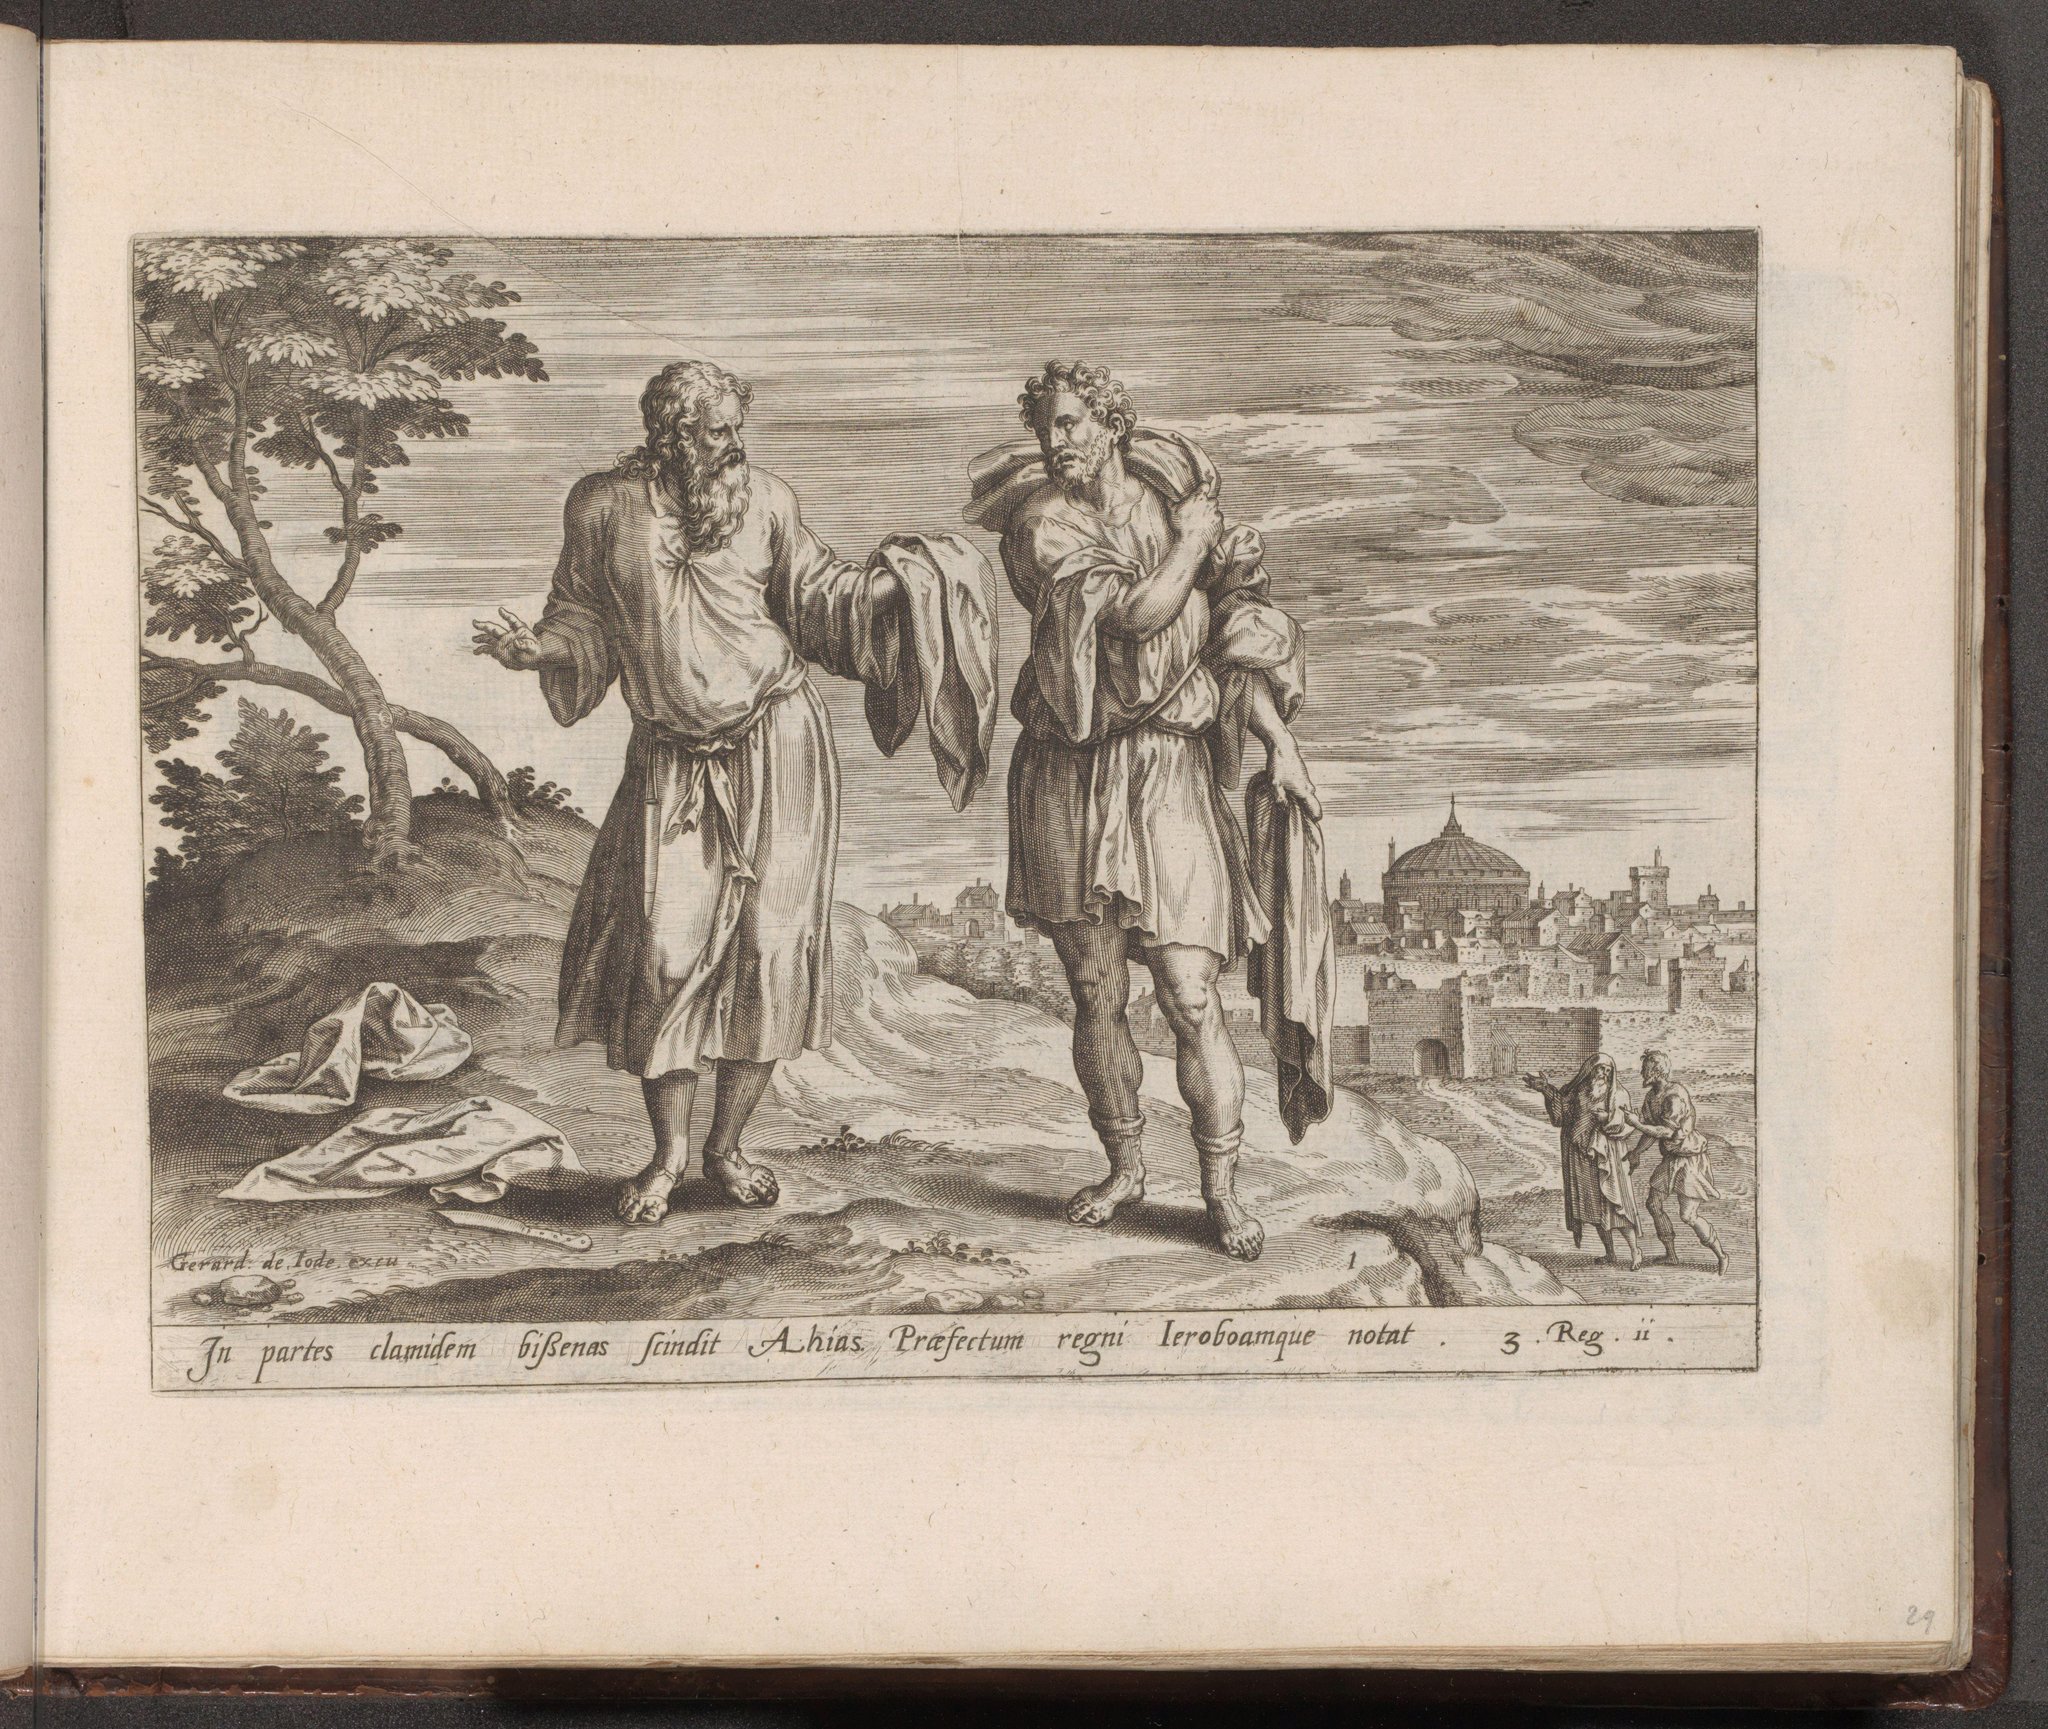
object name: print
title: Historia Roboam et Jeroboam (...)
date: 1579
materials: paper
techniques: engraving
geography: antwerp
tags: meeting of jeroboam and the prophet ahijah; ahijah rends his garment in twelve pieces, ten of which he gives to jeroboam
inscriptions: caption: ‘In partes clamidem...Ieroboamque notat. 3. Reg. 2’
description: De profeet Achia heeft zijn mantel in twaalf stukken gescheurd en overhandigt tien stukken aan Jerobeam. De gescheurde mantel staat symbool voor de splitsing van het Joodse volk. Jerobeam werd koning van tien van de twaalf stammen. Onder de voorstelling een verwijzing in het Latijn naar de Bijbeltekst in 1 Kon. 11. Prent maakt deel uit van een album.